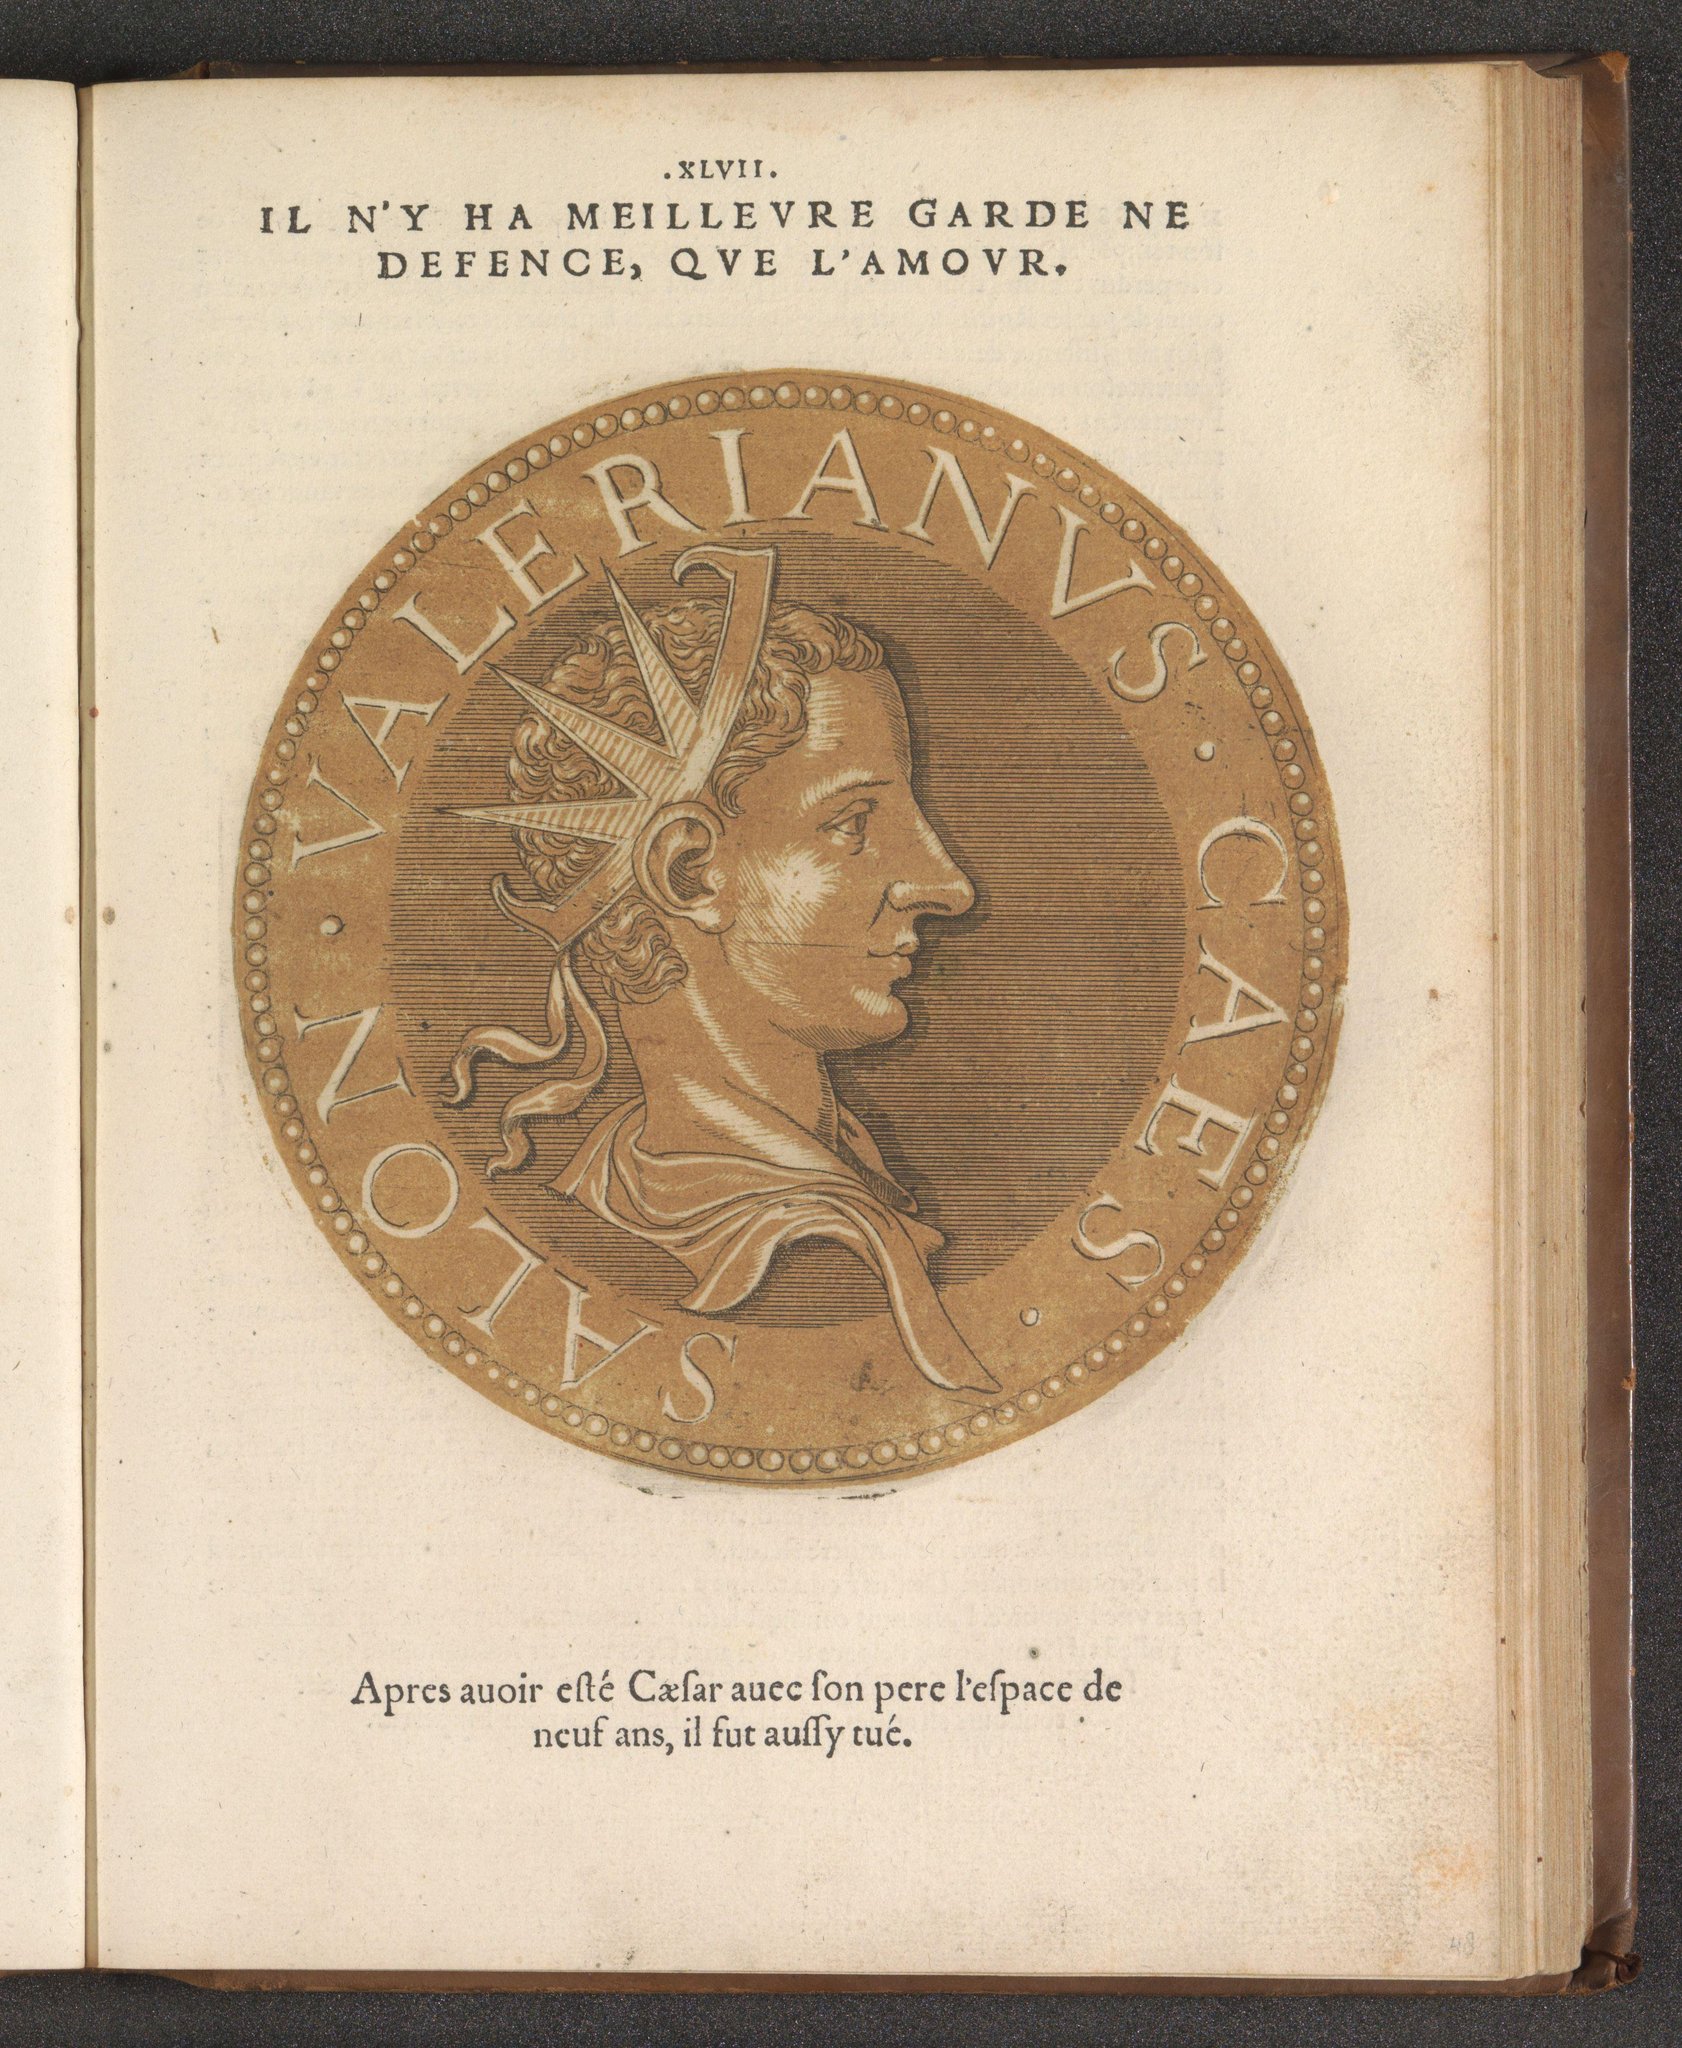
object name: print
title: Les images presque de tous les empereurs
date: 1557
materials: paper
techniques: woodcut, etching, letterpress printing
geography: antwerp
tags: emperor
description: Portret van keizer Salonius, op een munt met randschrift. De prent maakt deel uit van een boek over de keizers vanaf Julius Caesar tot en met Karel V en zijn broer Ferdinand.